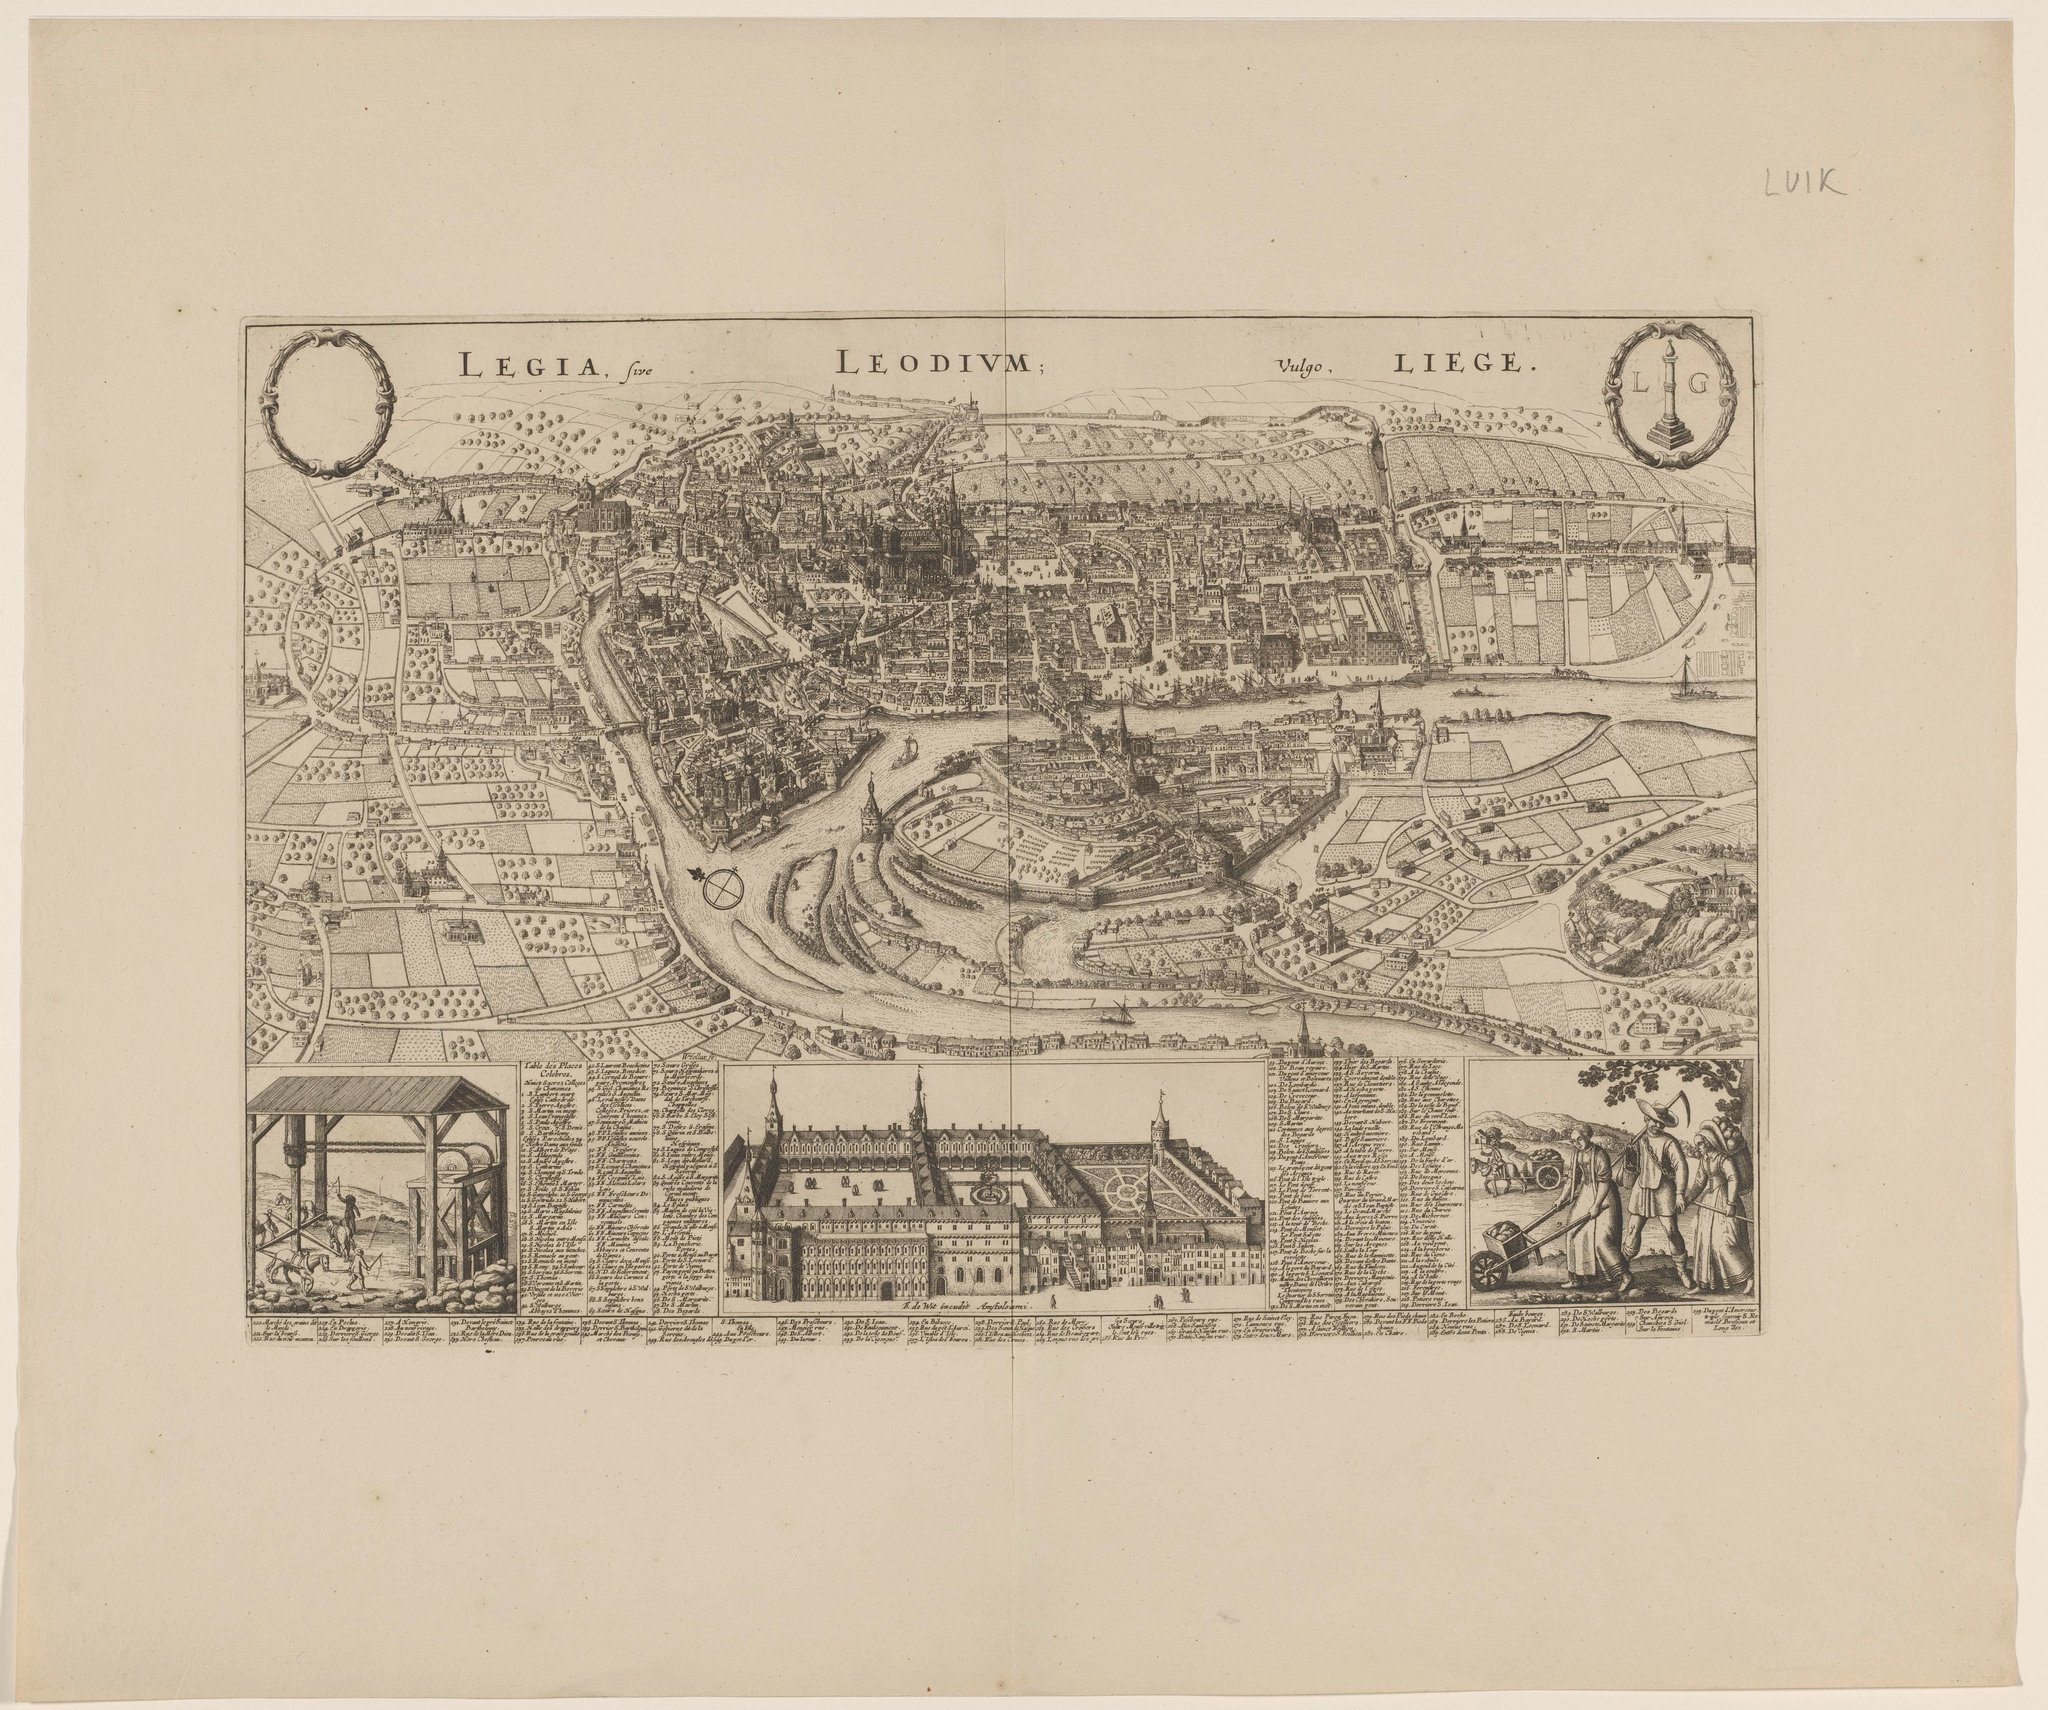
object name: print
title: Plattegrond van Luik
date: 1657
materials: paper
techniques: engraving, etching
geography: amsterdam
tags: miner, coat of arms (as symbol of the state, etc.) (+ city; municipal), palace, maps of cities, prospect of city, town panorama, silhouette of city, mine, liège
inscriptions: collector's mark: Lugt 2228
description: Plattegrond van Luik met gebouwen in vogelvluchtperspectief. Linksboven een leeg wapenschild, rechtsboven het wapen van Luik. Onder een legenda 1-295. Links- en rechtsonder voorstellingen die te maken hebben met de mijnbouw. Onder, in het midden, een gezicht op het Paleis van de Prins-bisschoppen van Luik.